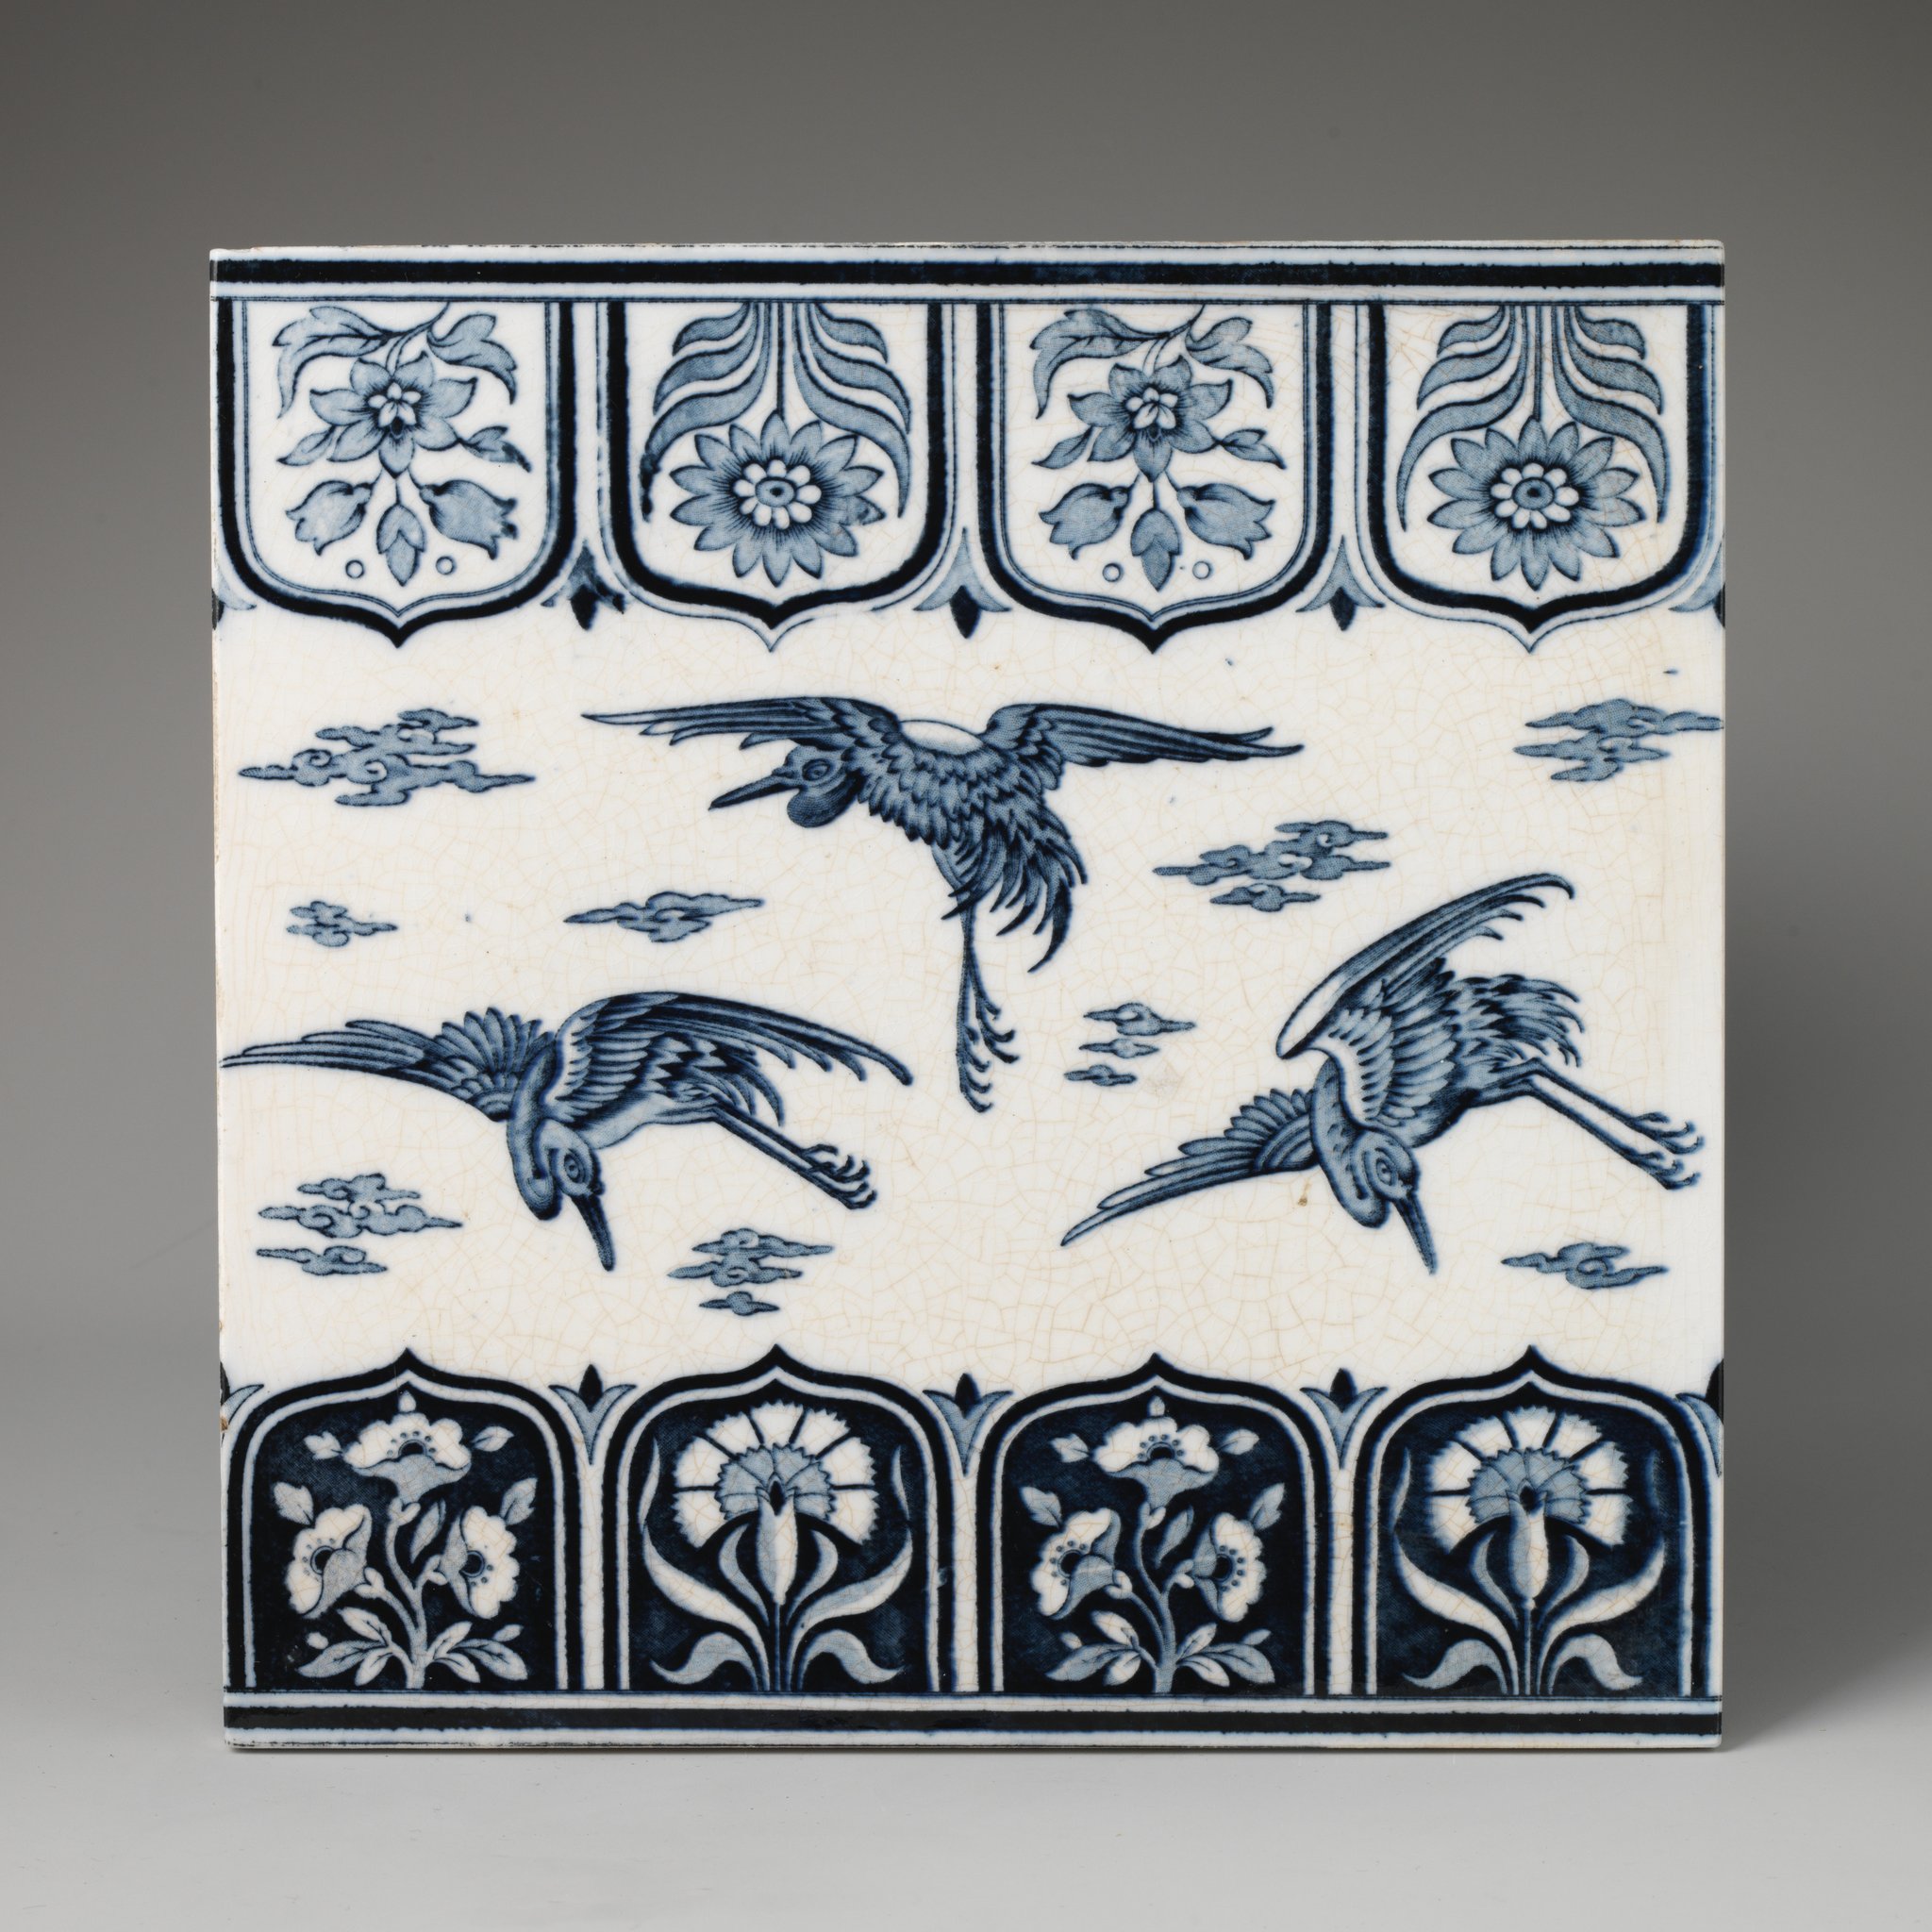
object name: tile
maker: christopher dresser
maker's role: designer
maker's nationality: british, scottish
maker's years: 1834-1904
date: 1875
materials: earthenware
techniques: glazing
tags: birds,flowers